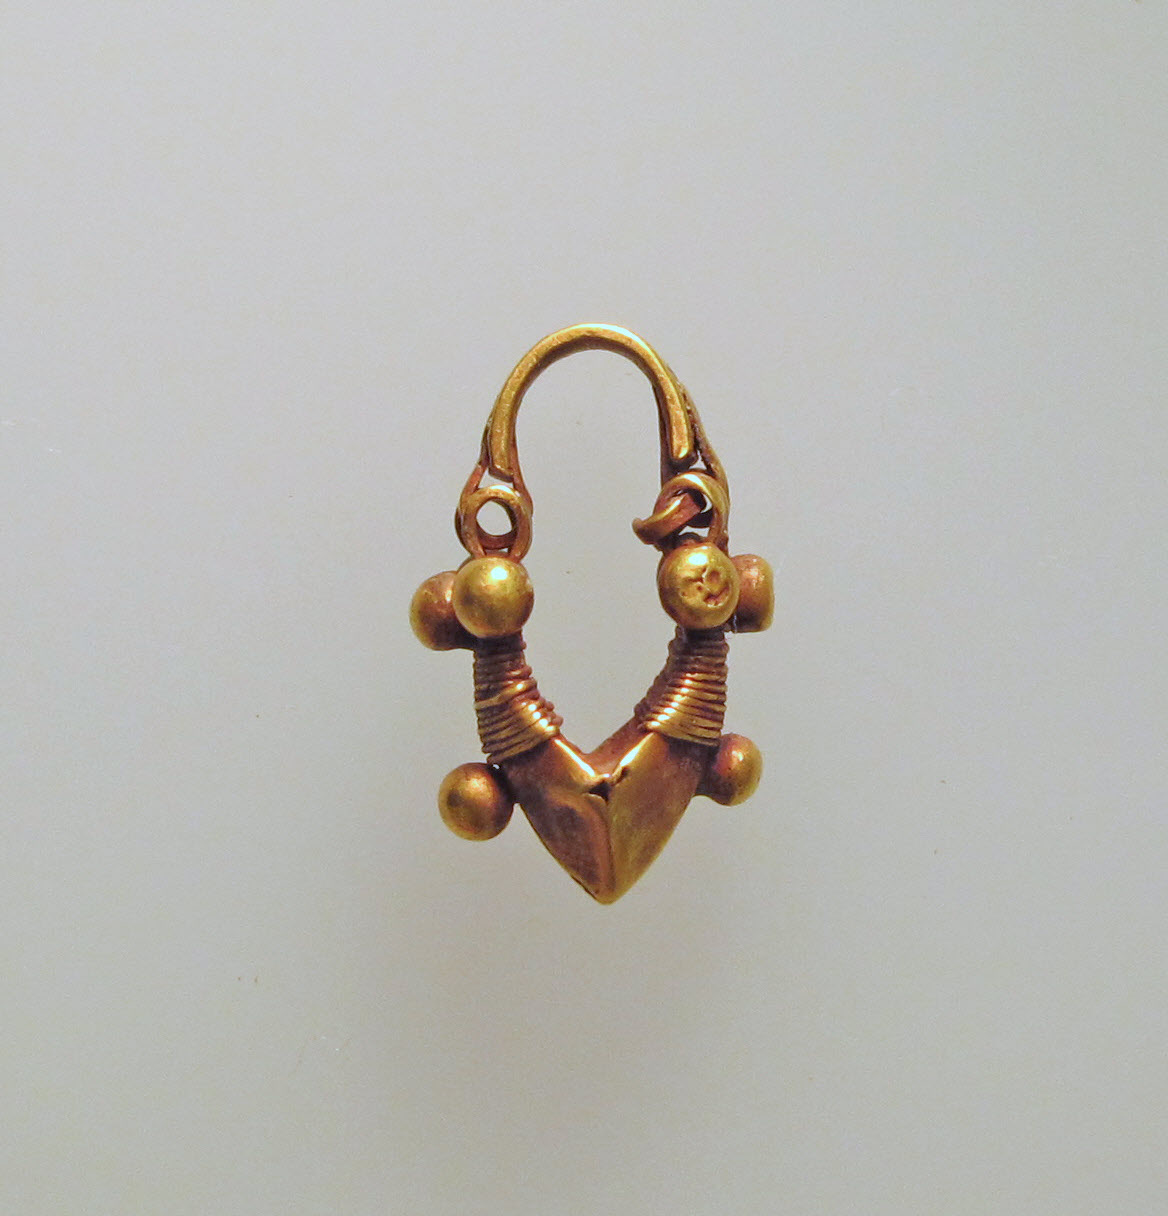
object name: earring, boat shaped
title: Earring, boat-shaped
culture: cypriot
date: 3900 BCE-100 CE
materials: gold